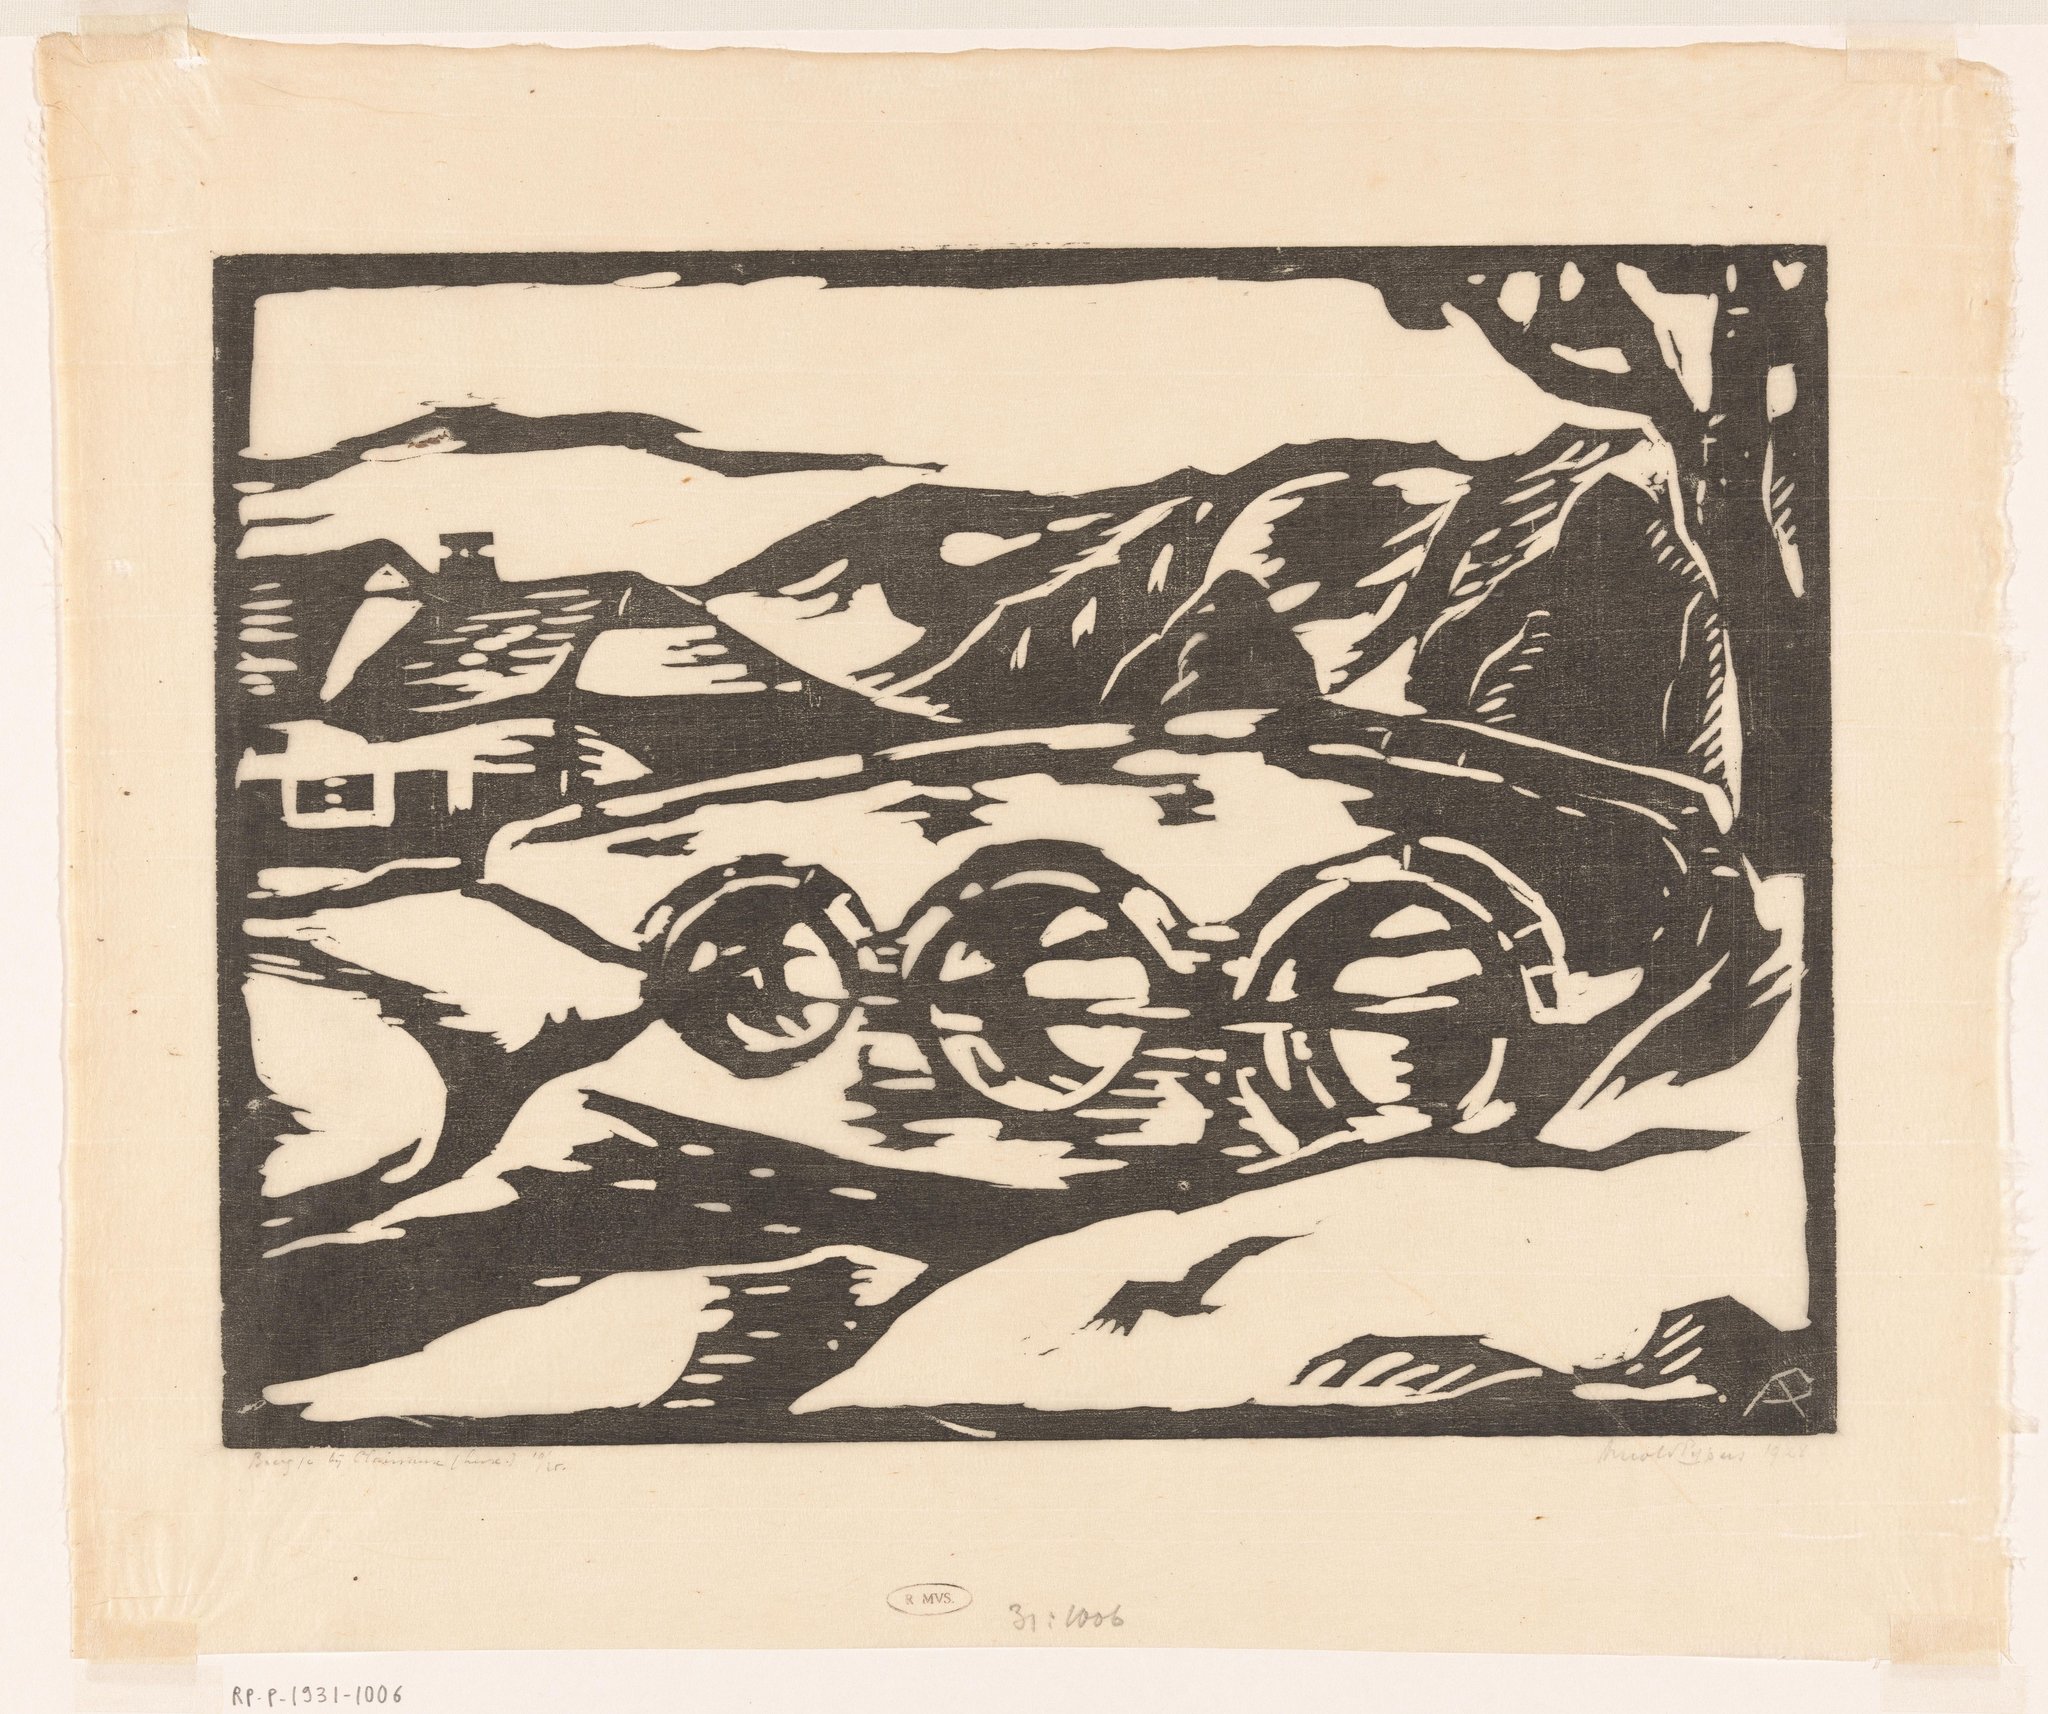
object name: print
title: Brugje bij Clervaux, Luxemburg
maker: arnold pijpers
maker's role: print maker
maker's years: 1900-1951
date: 1928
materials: paper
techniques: woodcut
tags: bridge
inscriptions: date, collector's mark: Lugt 2228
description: Een brug met drie bogen over het water. Op de achtergrond een huis en heuvels.